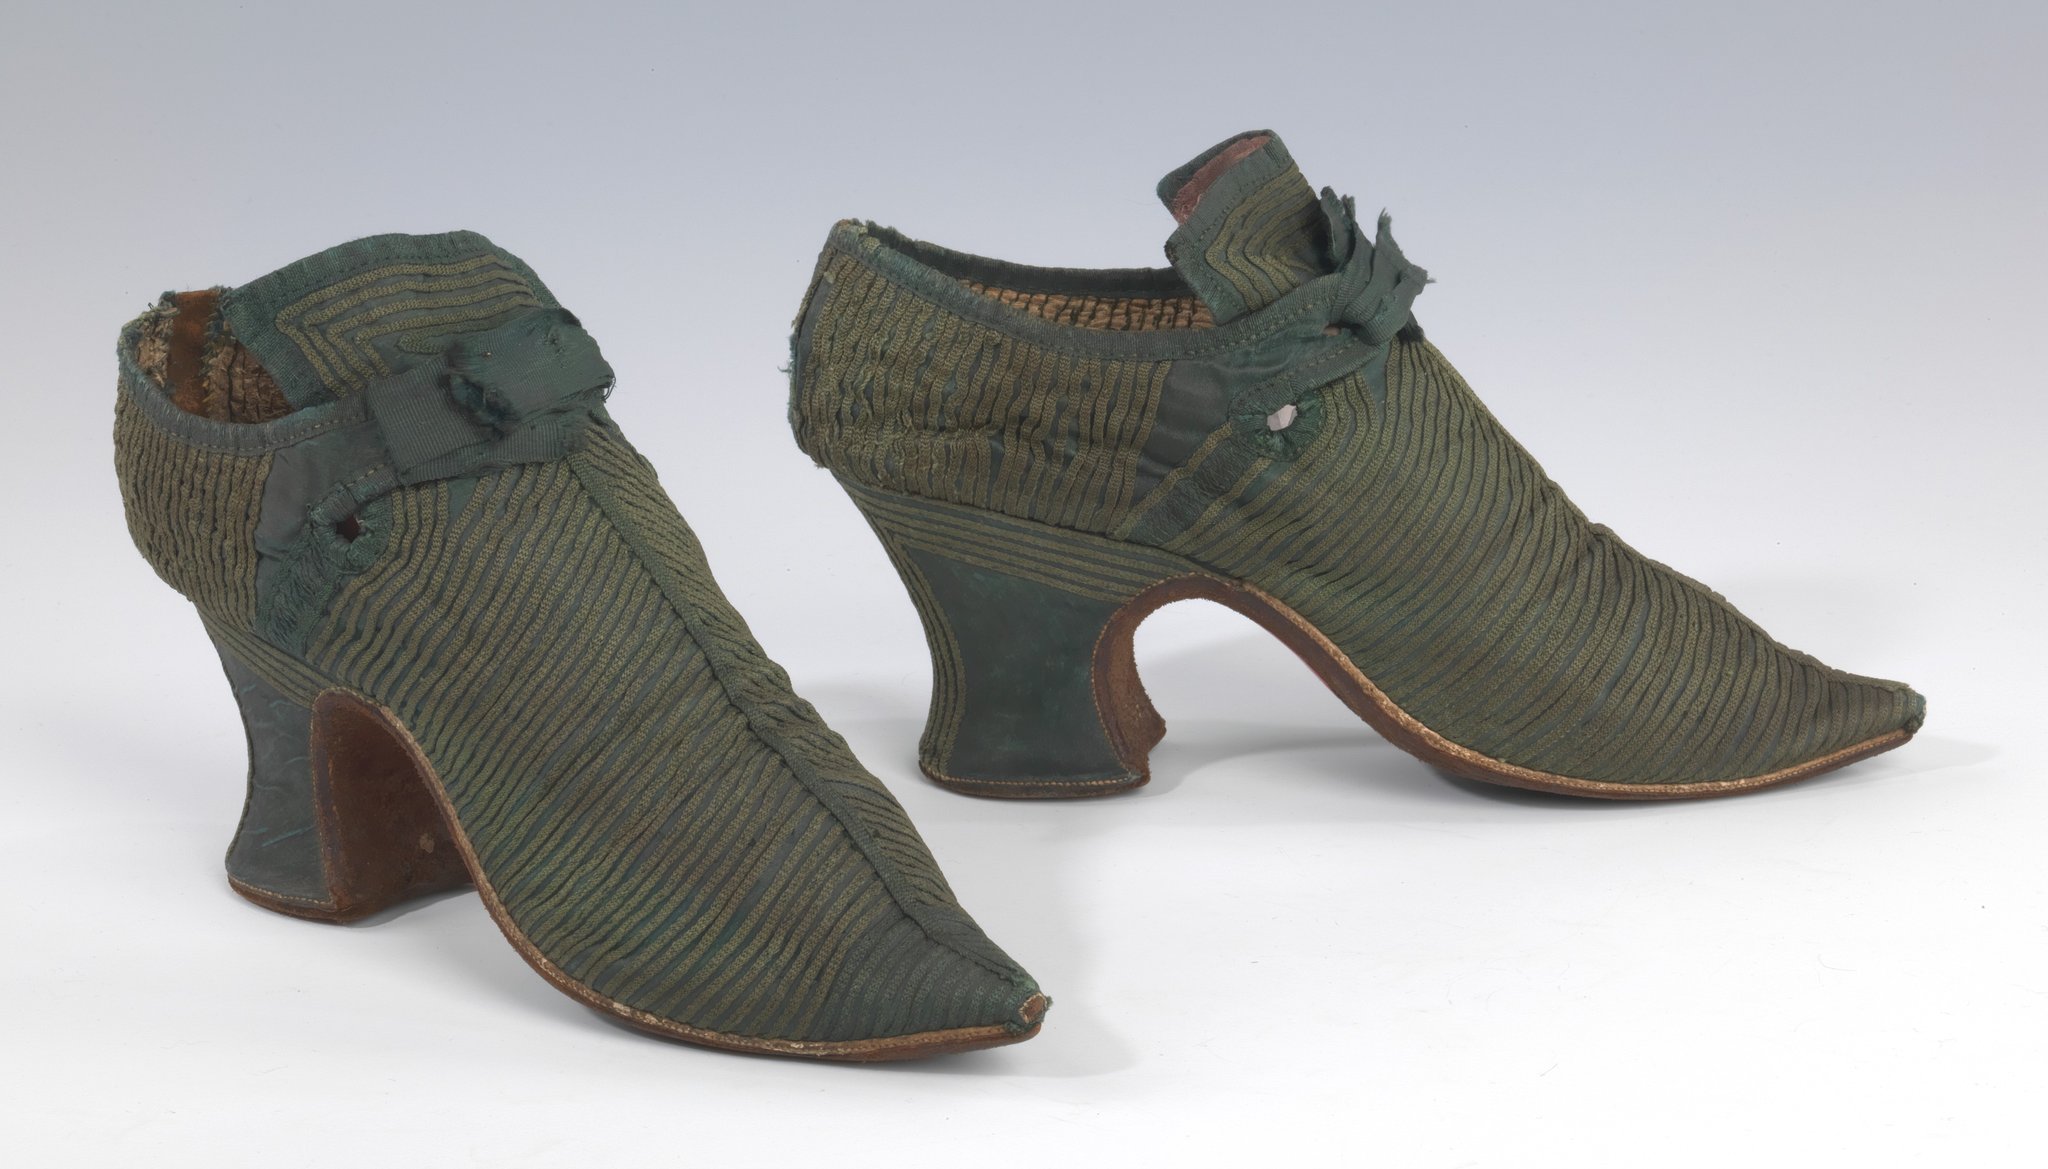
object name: shoe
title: Shoes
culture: british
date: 1700-1739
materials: silk